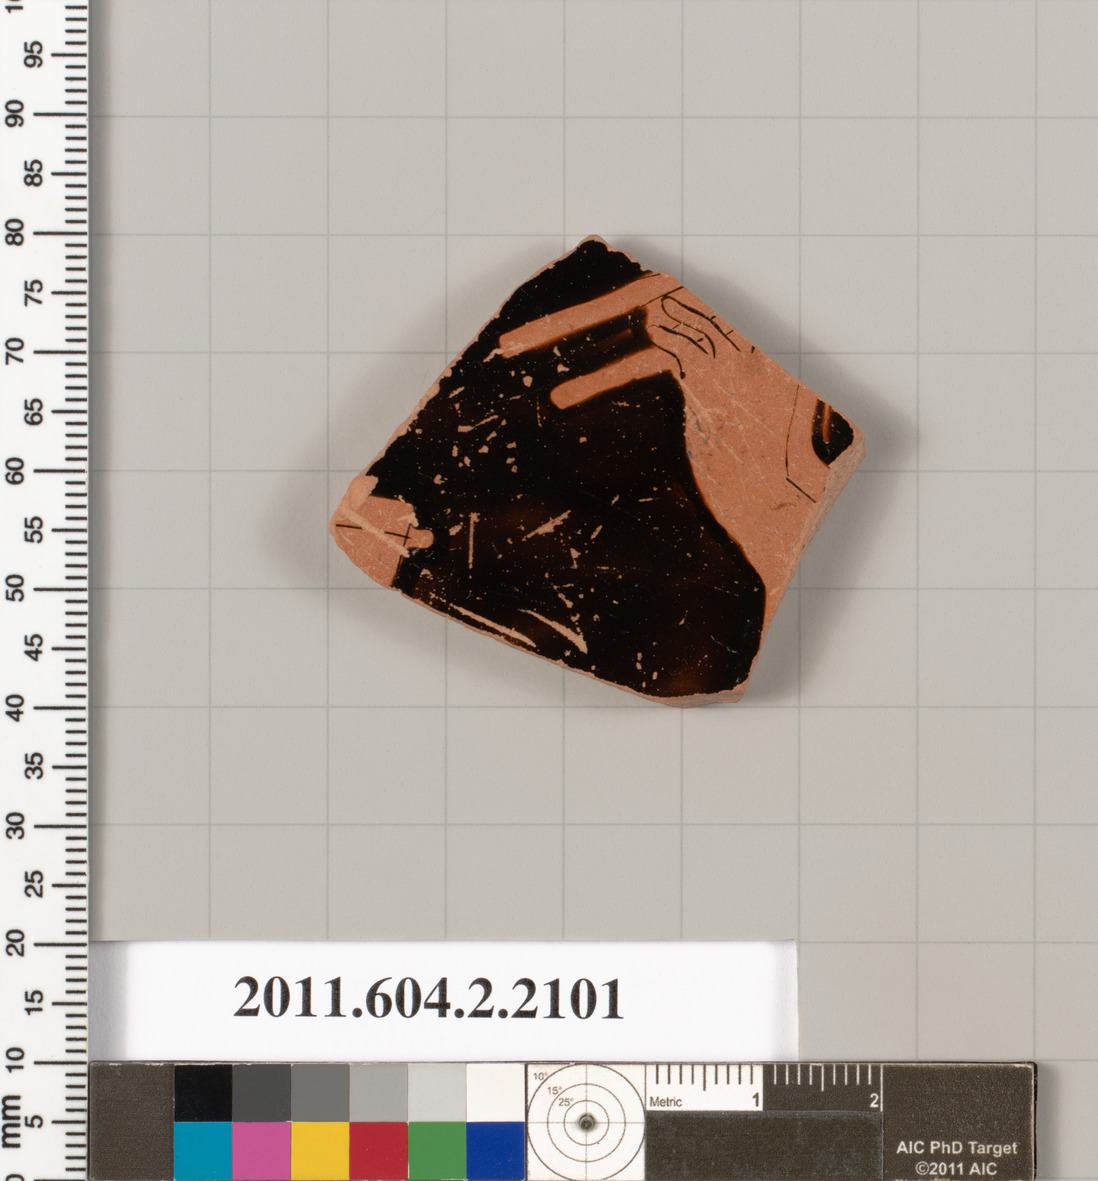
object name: pot fragment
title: Terracotta fragment of a pot; glazed on the inside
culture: greek, attic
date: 460-440 BCE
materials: terracotta